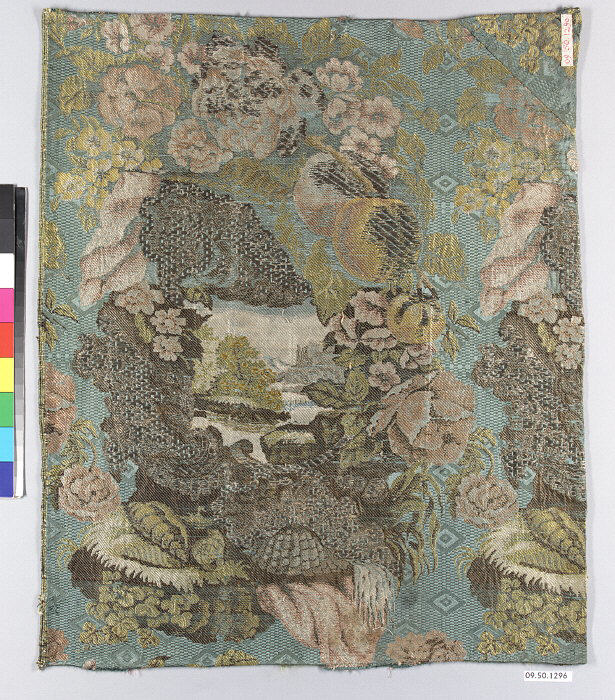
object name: piece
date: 1730-1740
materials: metal thread, silk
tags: flowers,leaves